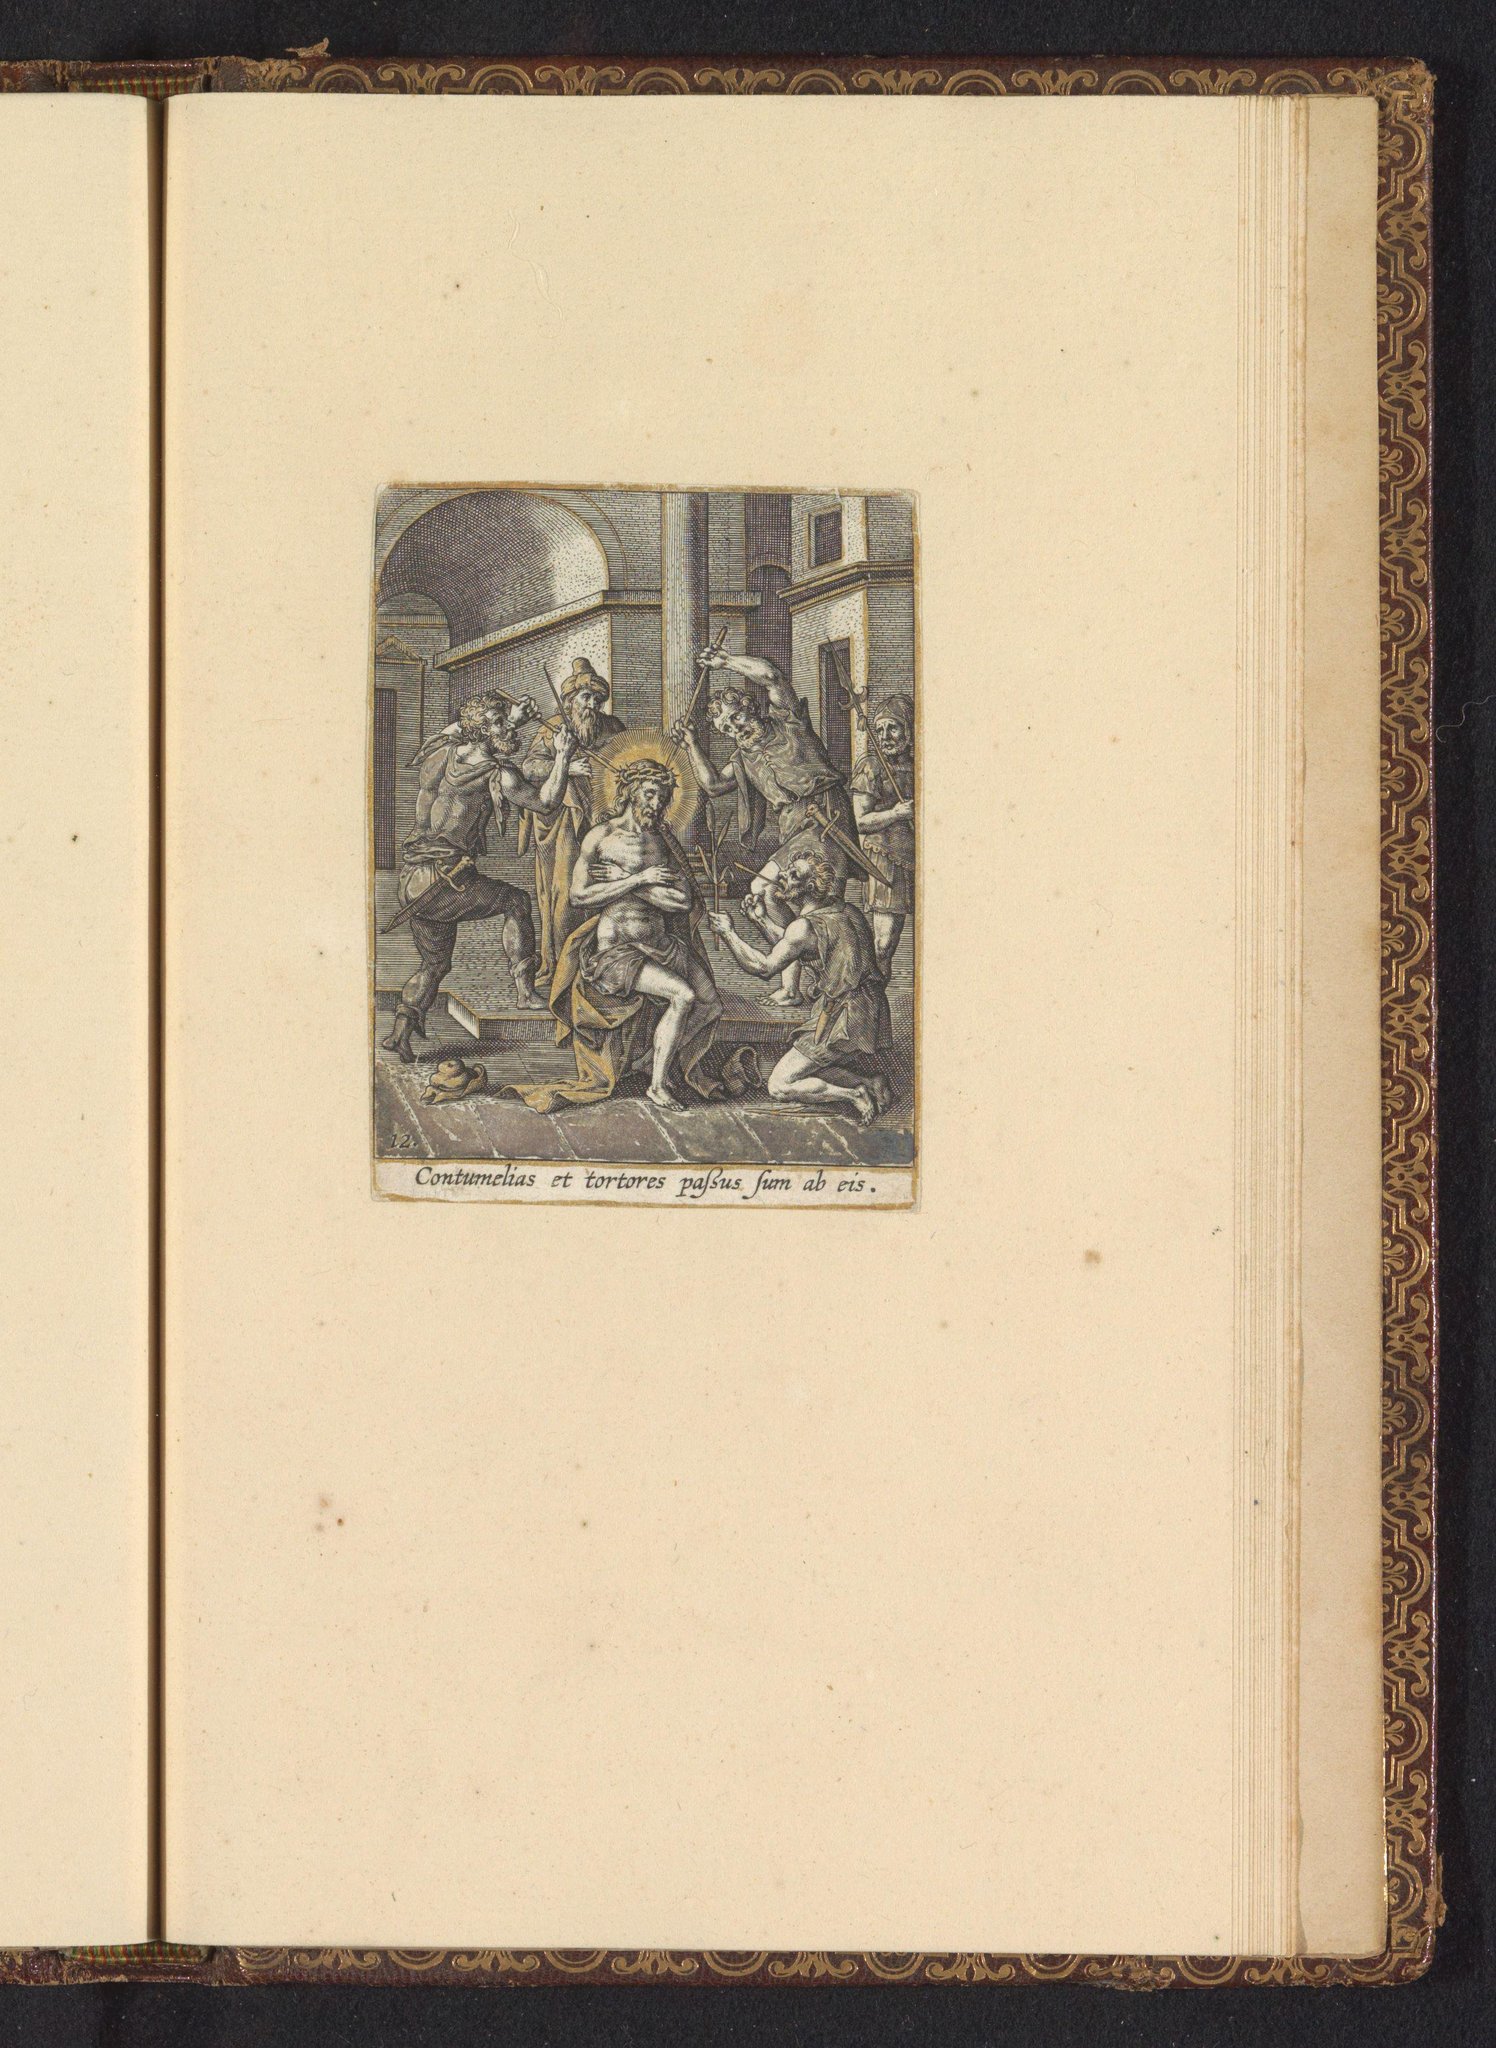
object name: print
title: Doornenkroning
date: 1580-1590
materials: gold, paper, silver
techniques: engraving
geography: antwerp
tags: the crowning with thorns: soldiers with sticks place a thorny crown on christ's head and give him a reed (matthew 27:27-31; mark 15:16-20; john 19:2-3)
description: Doornenkroning. Onderdeel van de prentserie over de passie van Christus: Passio et resurrectio D.N. Iesu Christi. Edita et excusa ab Ad. Collaert. In prentalbum met twee reeksen van respectievelijk 34 en 24 gravures met scènes uit het leven en het lijdensverhaal van Christus.